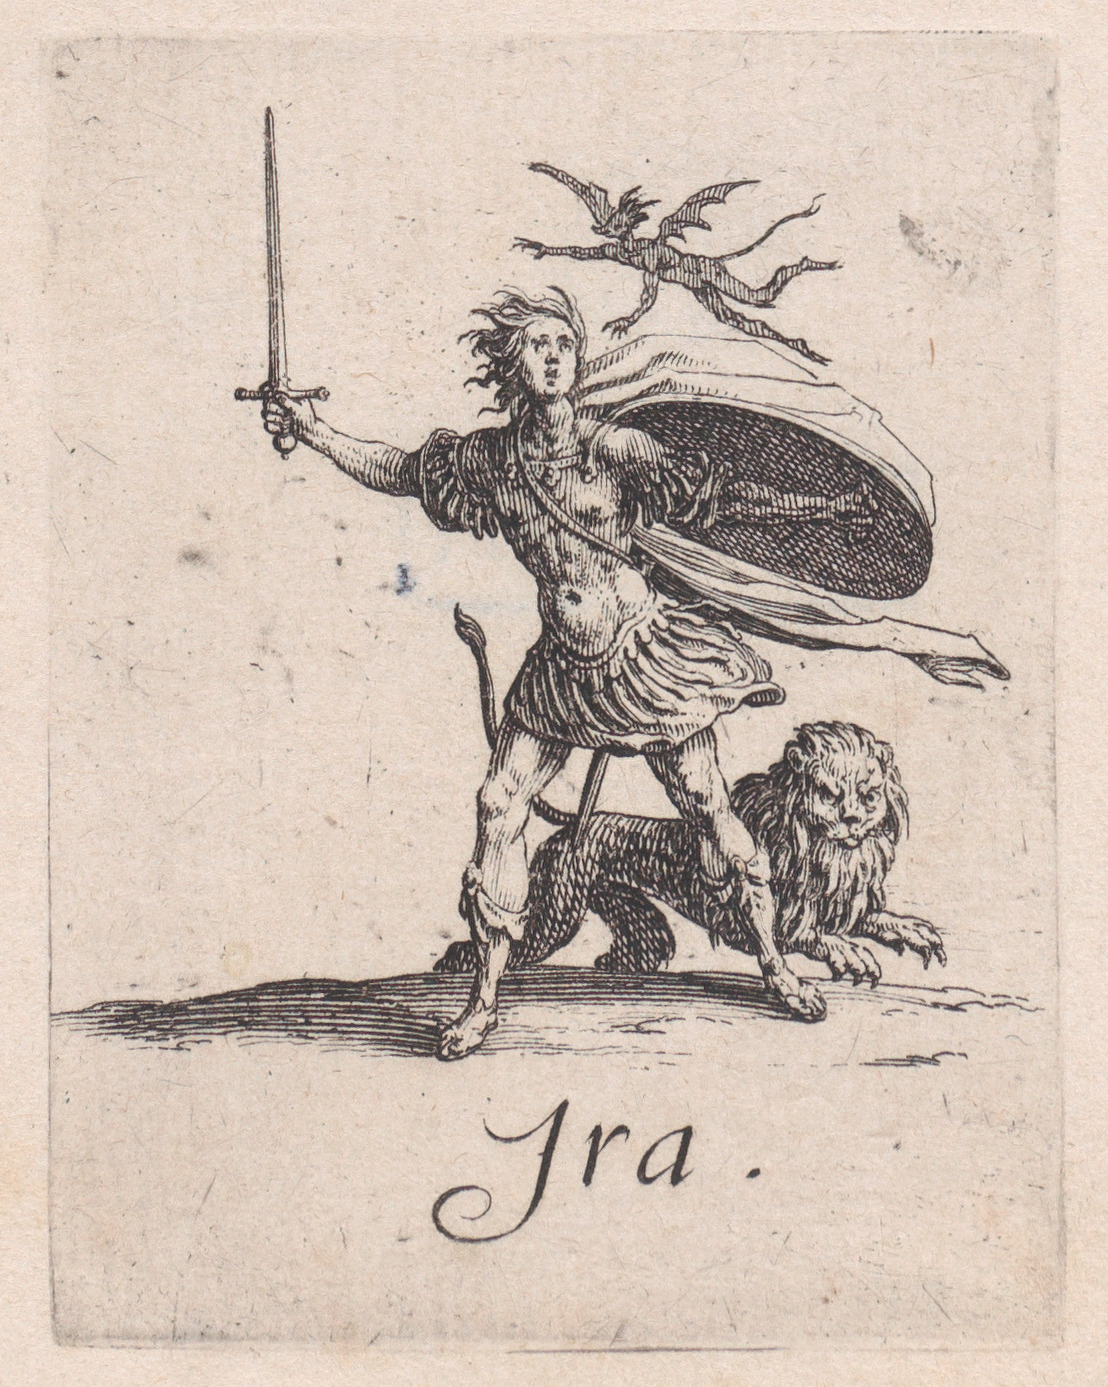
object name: print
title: La Colère (Wrath), from "Les Péchées Capitaux" (The Deadly Sins)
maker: jacques callot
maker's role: artist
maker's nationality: french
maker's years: 1592-1635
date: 1620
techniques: engraving, etching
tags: shields,swords,men,lions